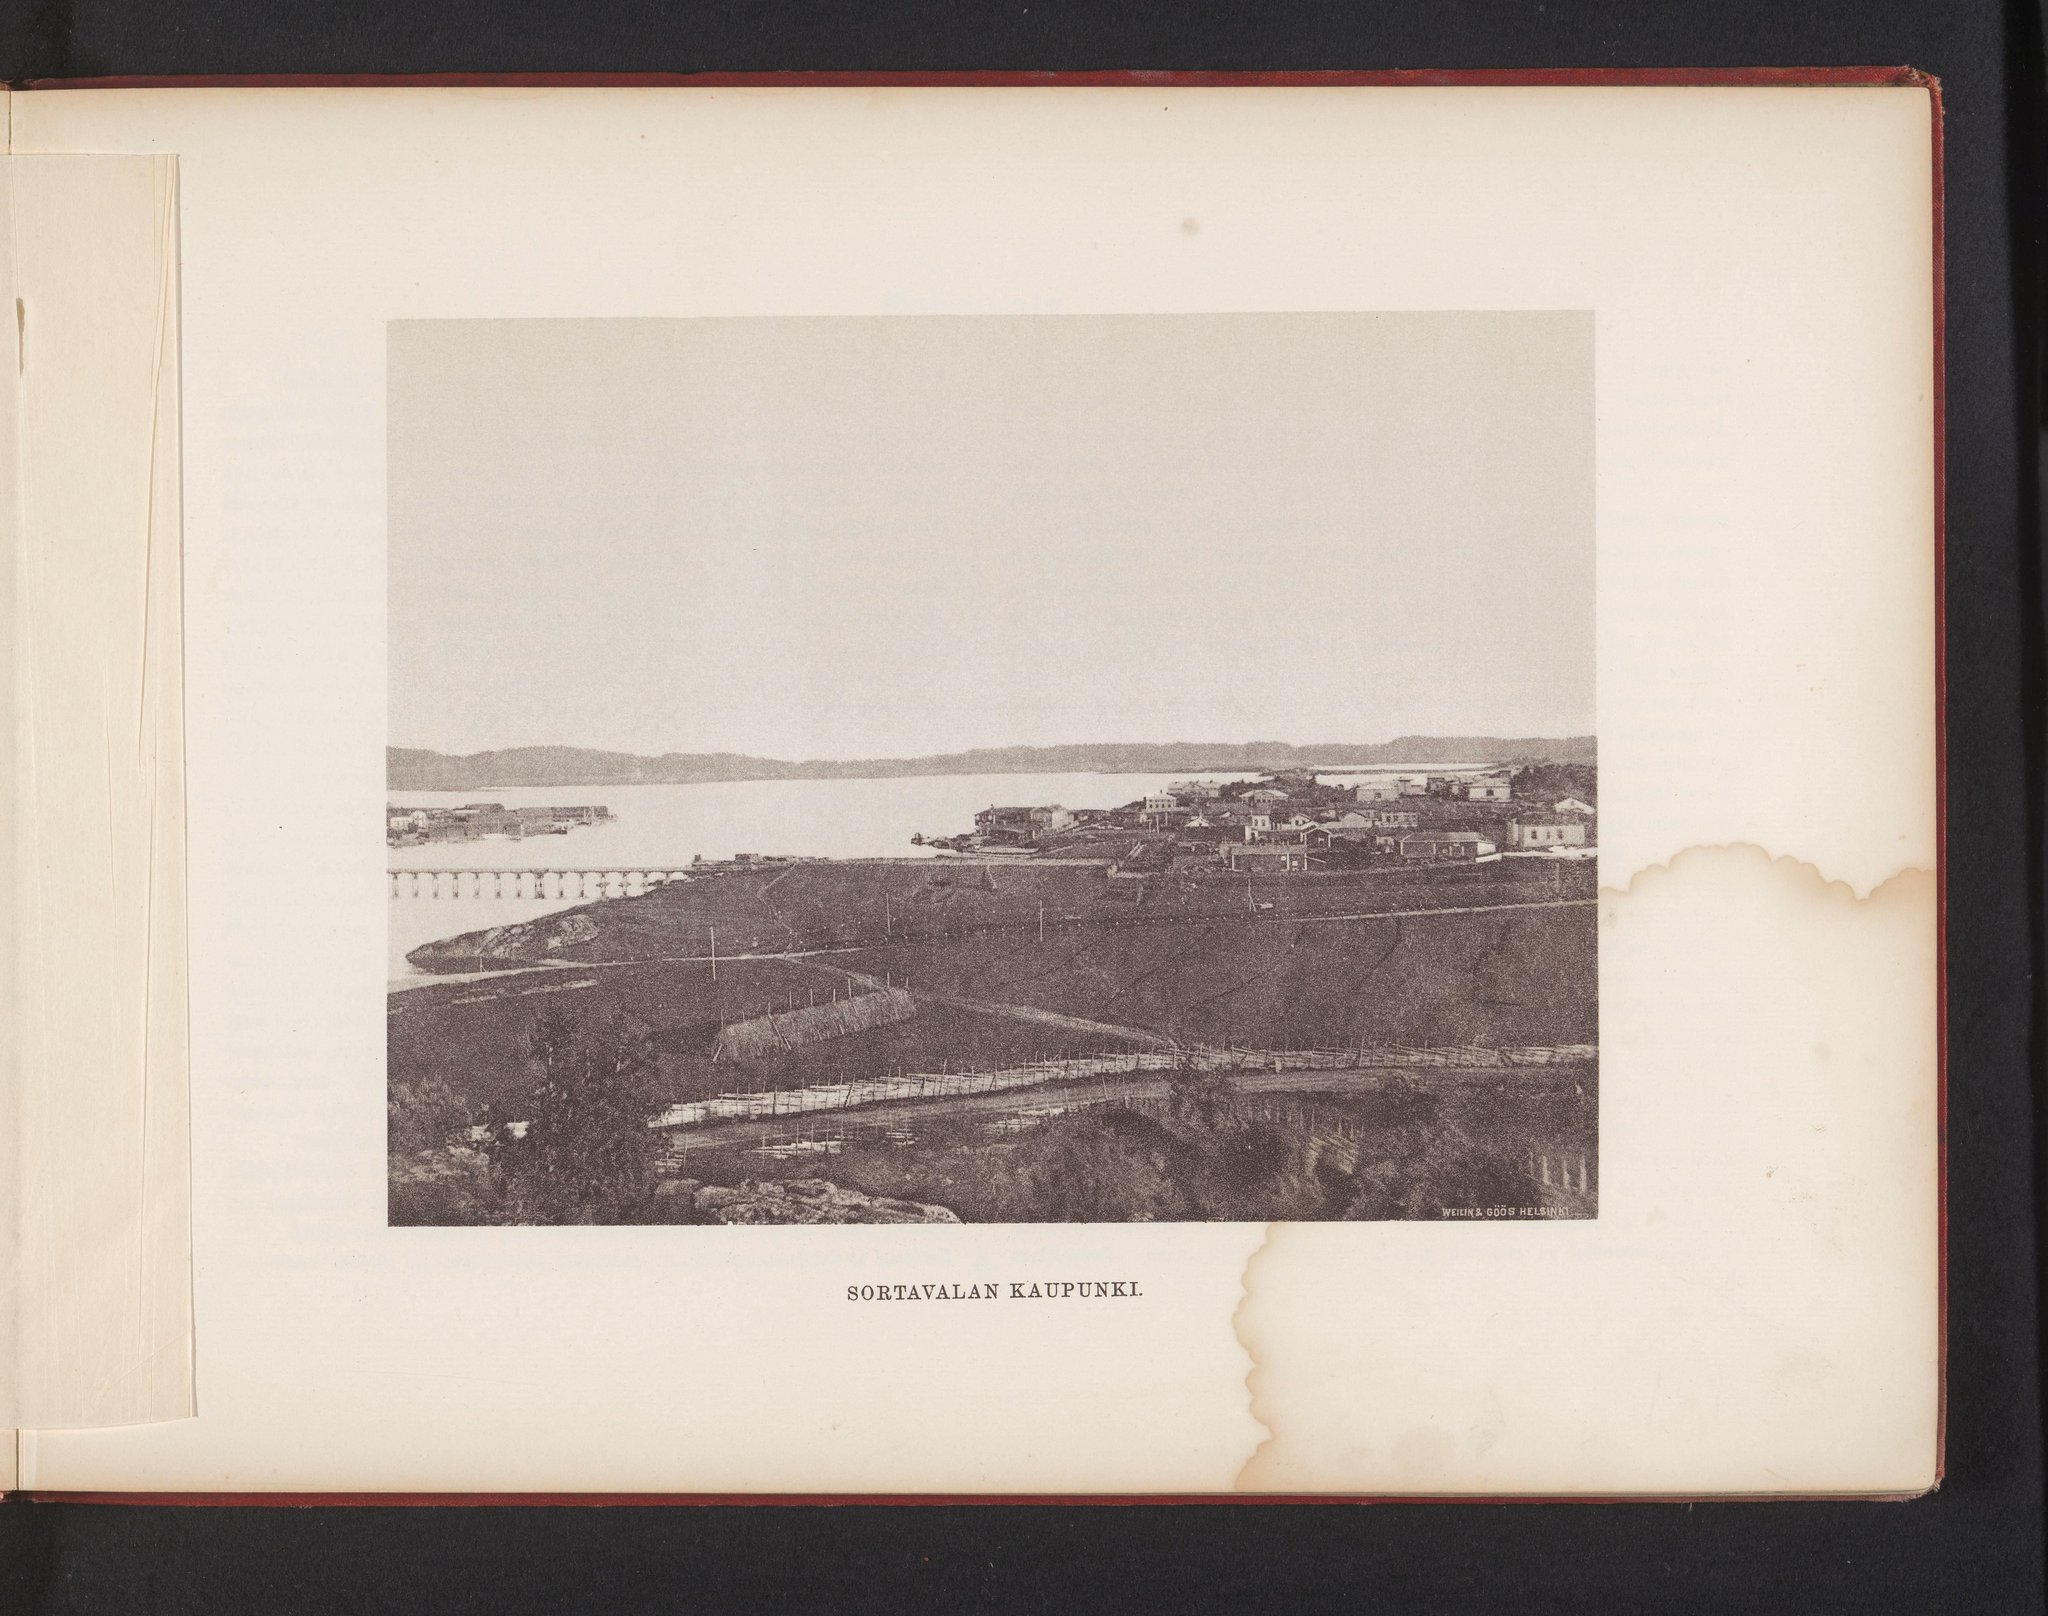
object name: photomechanical print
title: Gezicht op Sortavala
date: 1888-1893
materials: paper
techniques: autotype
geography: sortavala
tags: city-view in general; 'veduta', landscapes with waters, waterscapes, seascapes (in the temperate zone), bridge